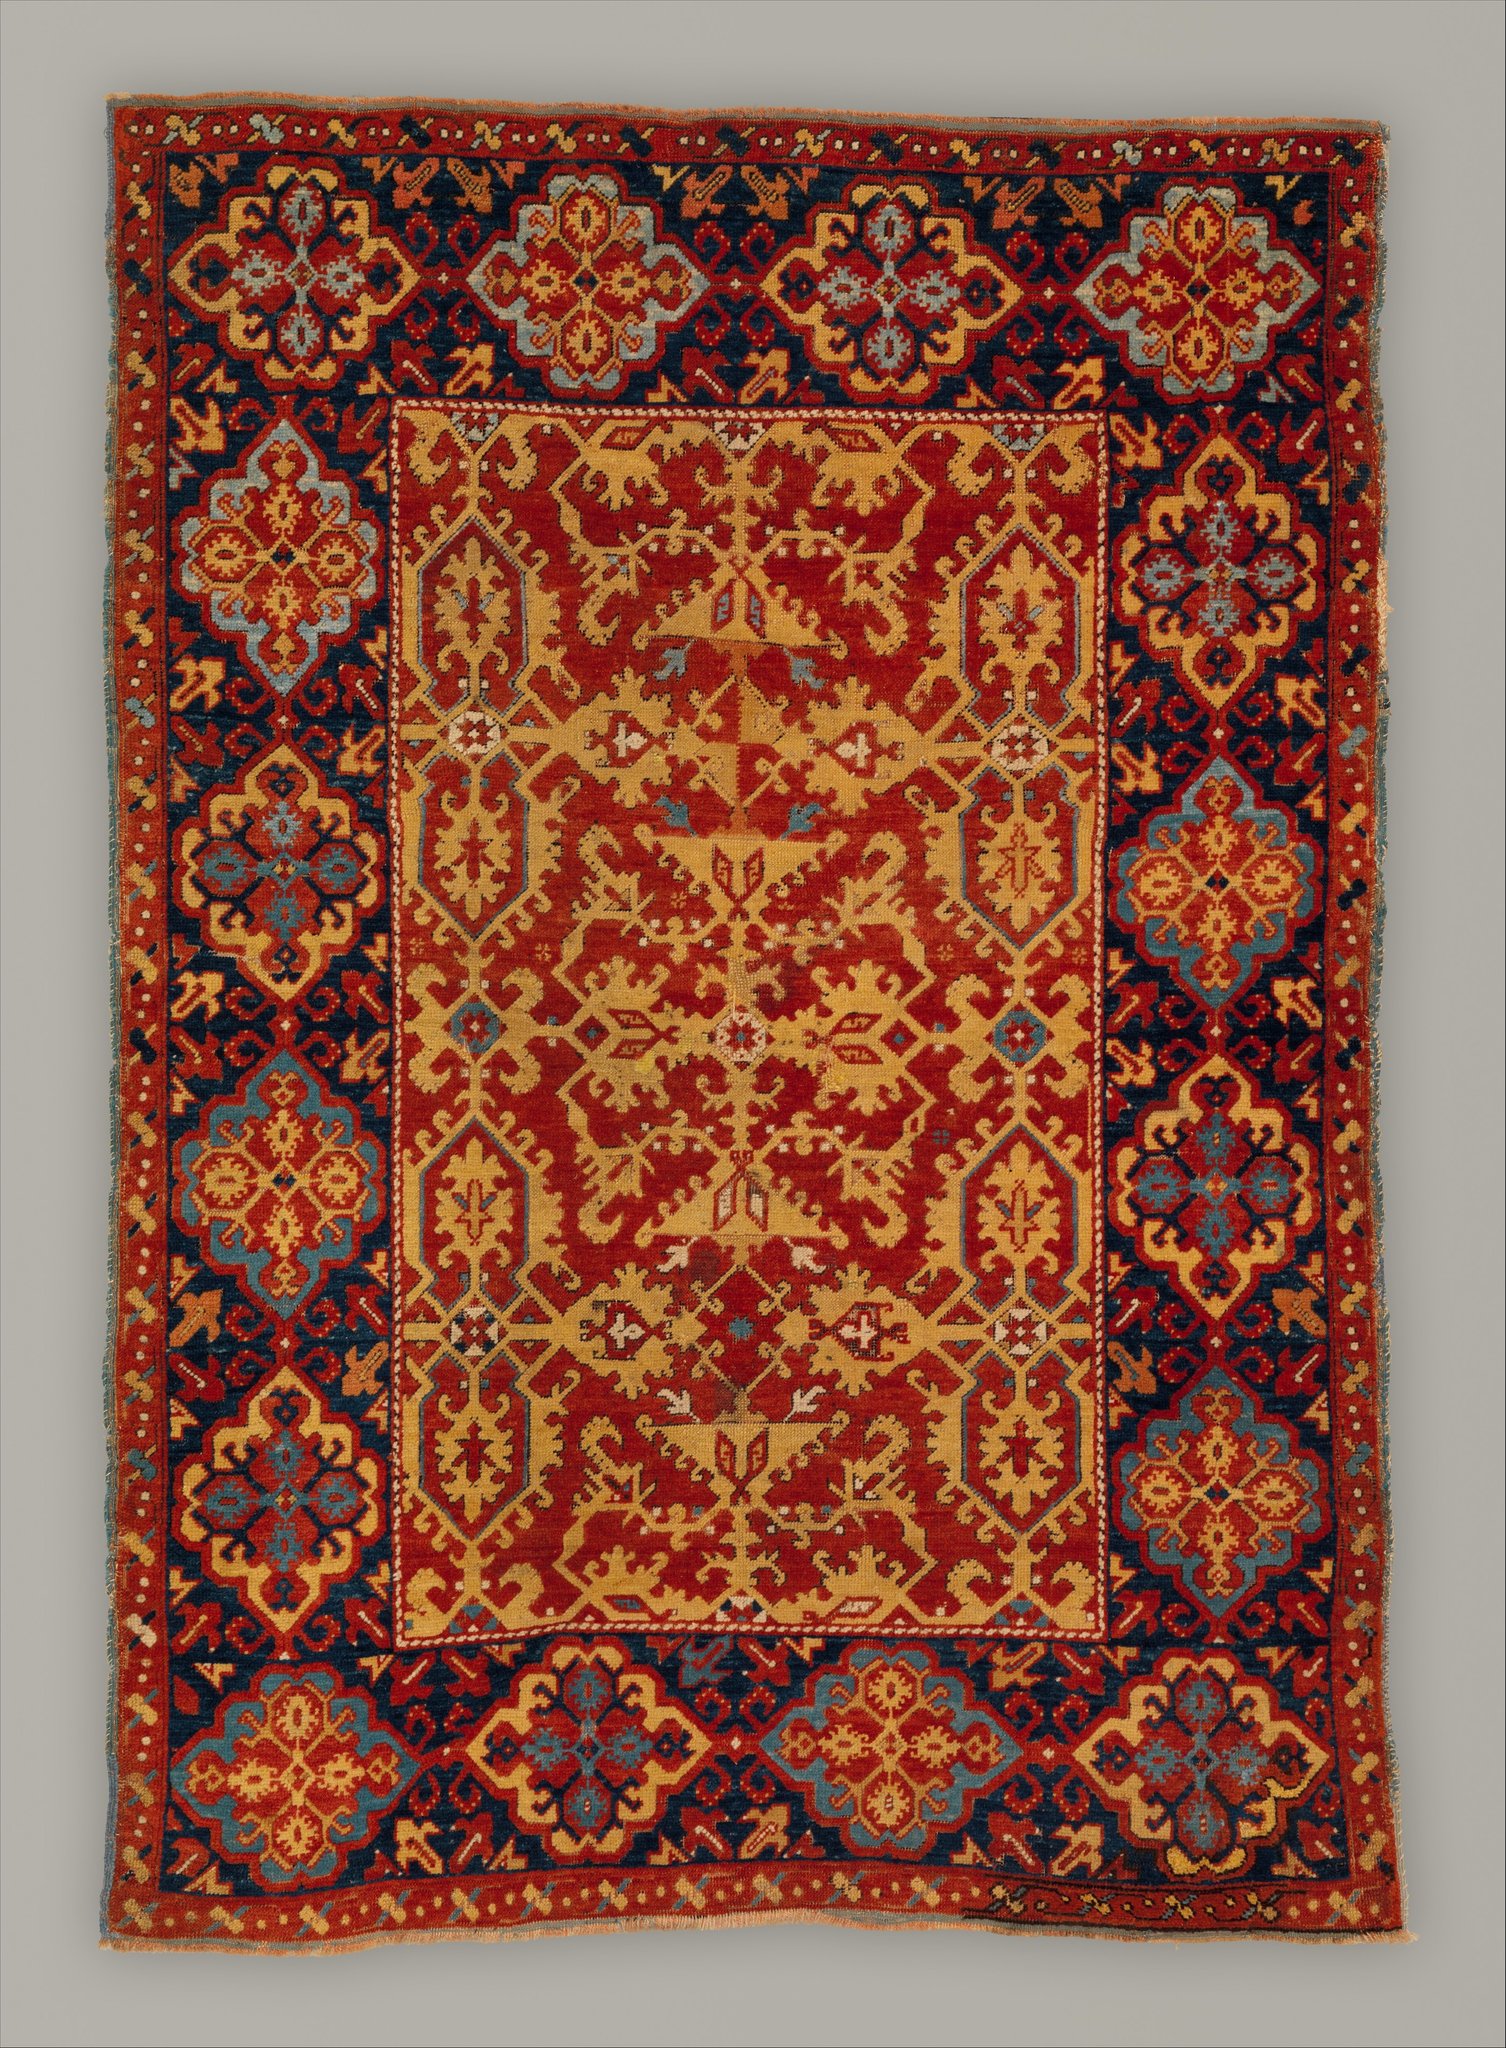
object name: carpet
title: "Ornamental Lotto" Carpet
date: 1601-1633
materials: wool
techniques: pile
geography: turkey